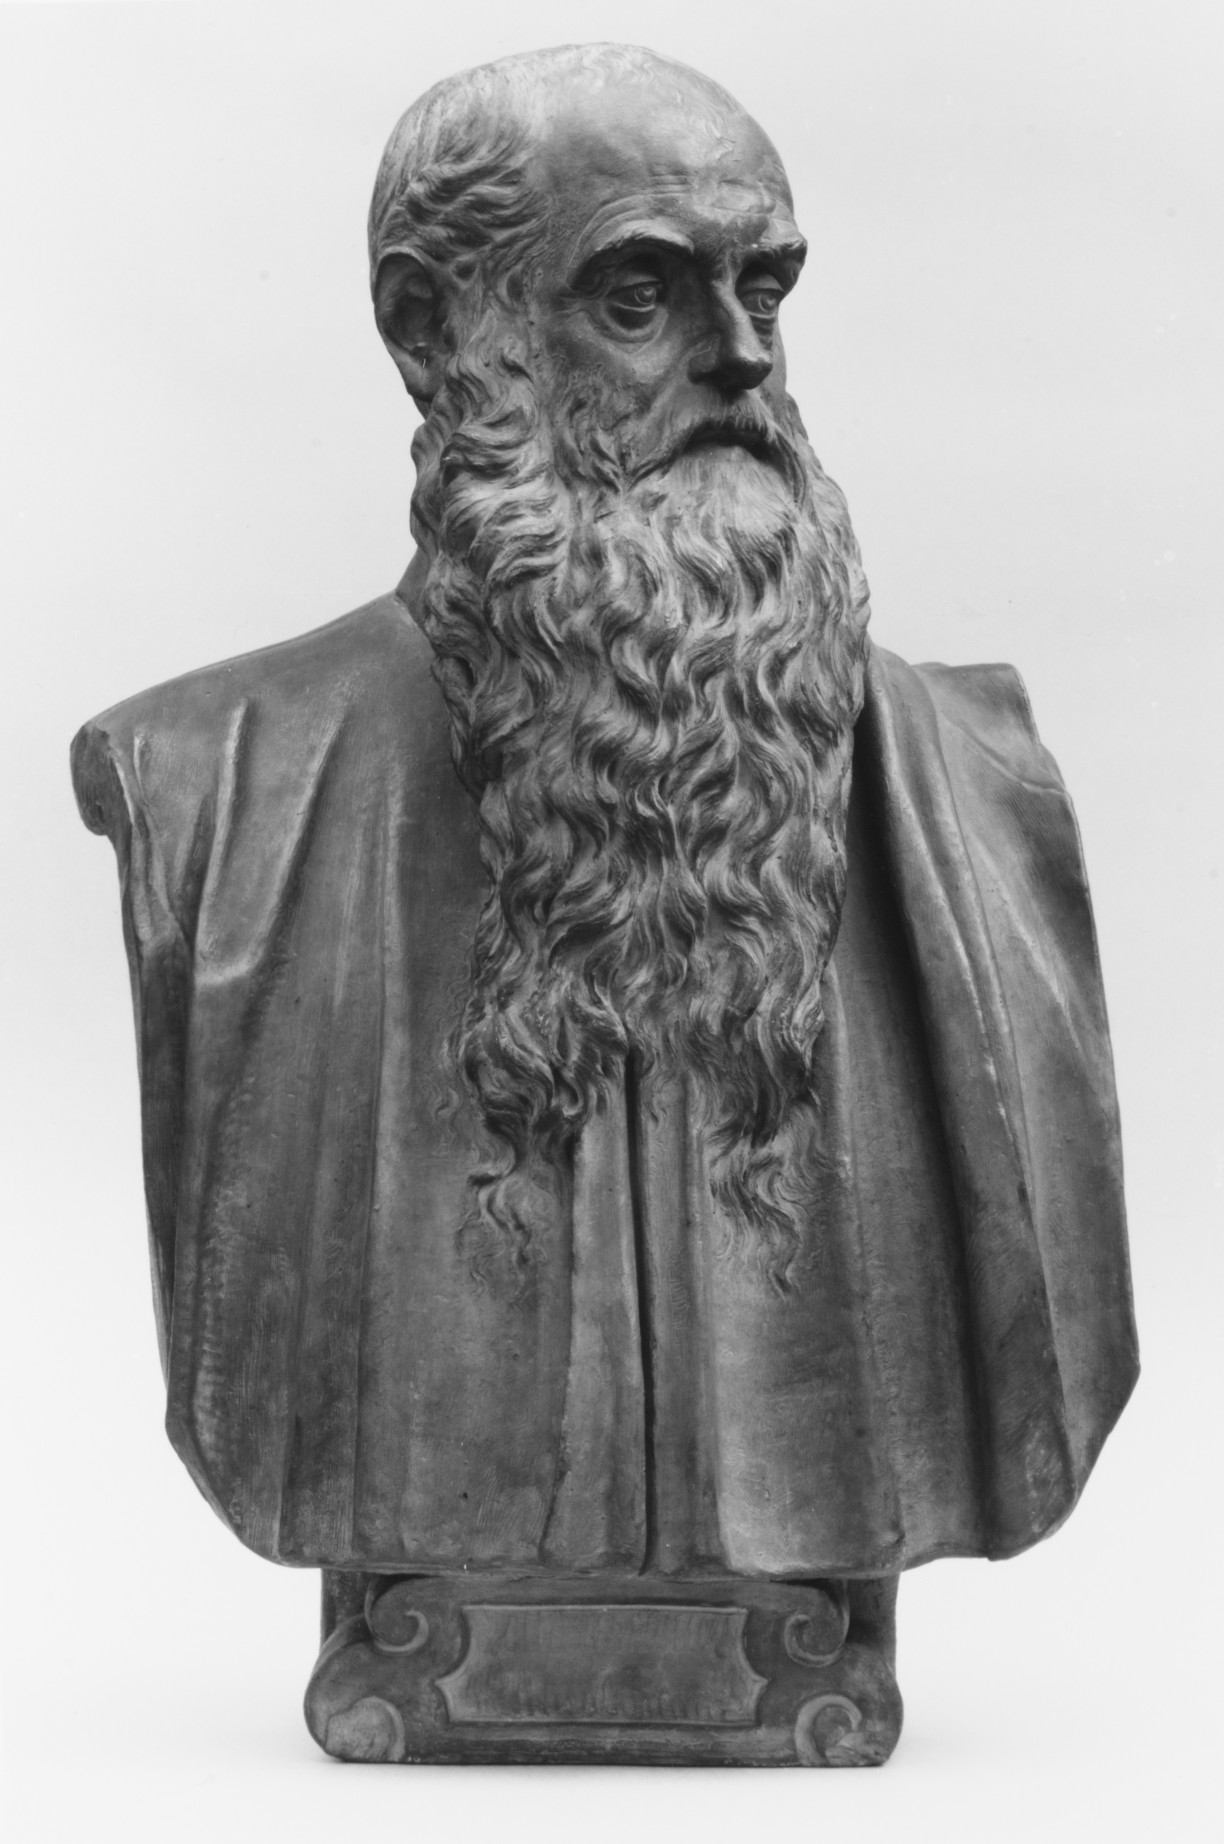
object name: bust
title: Apollonio Massa, Doctor of Medicine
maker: alessandro vittoria (alessandro vittoria di vigilio della volpa)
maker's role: artist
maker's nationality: italian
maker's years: 1525-1608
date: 1801-1900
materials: terracotta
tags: portraits,doctors